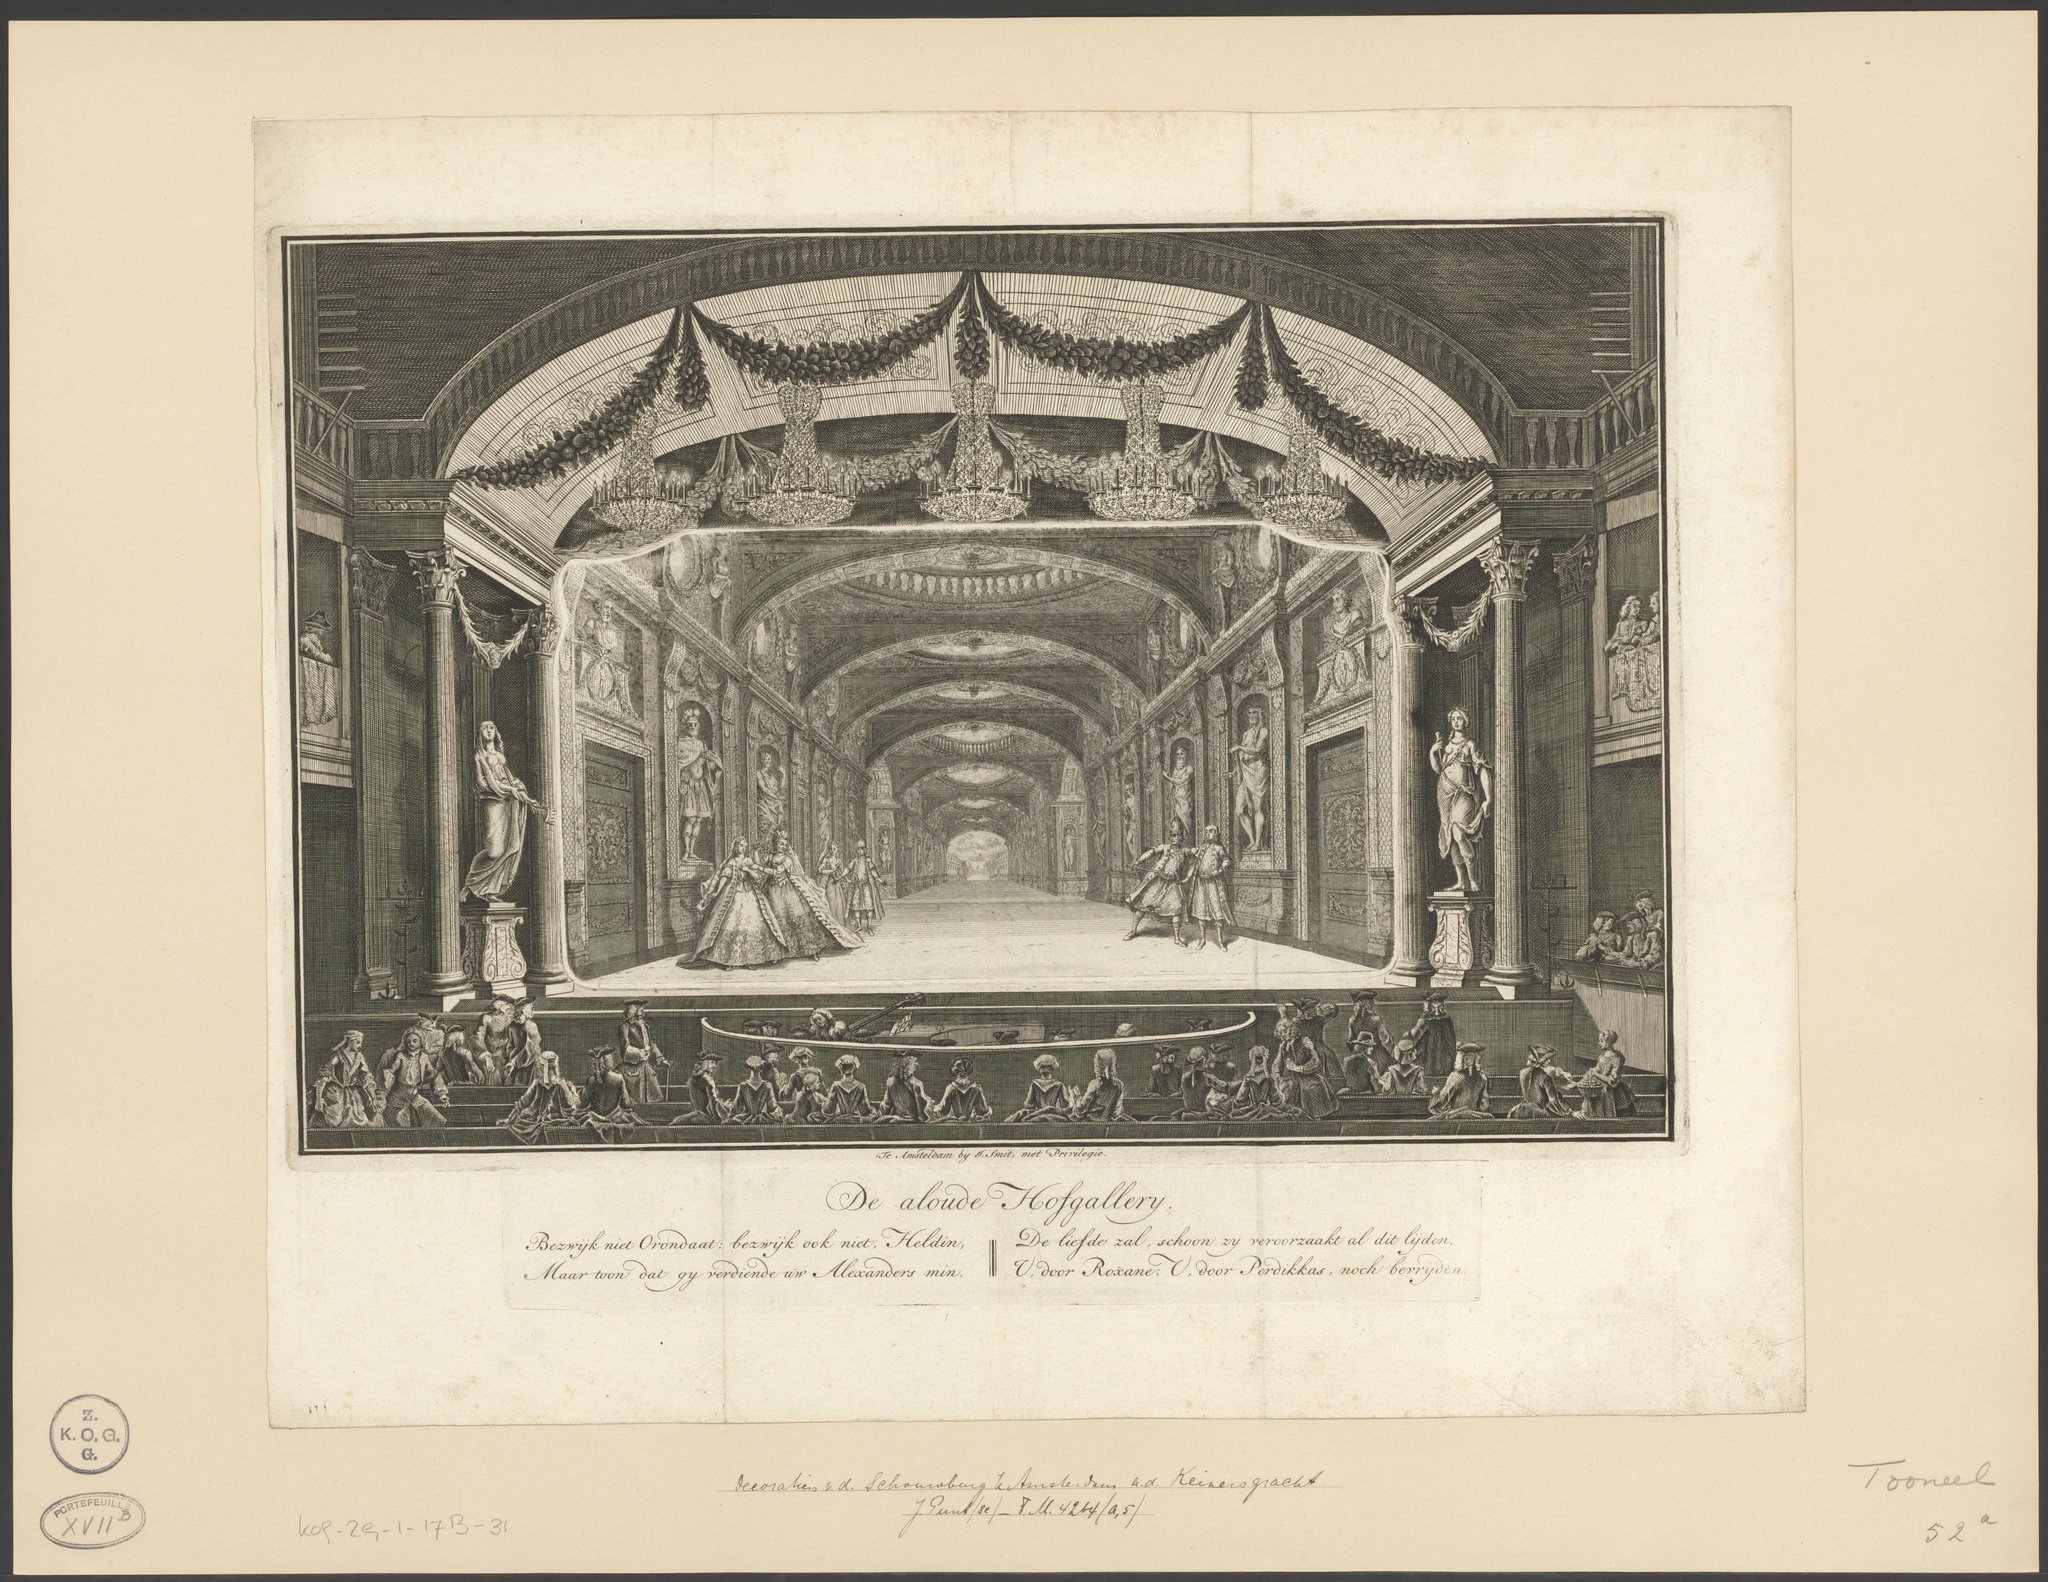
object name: print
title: Schouwburg met toneeldecor: De aloude Hofgallery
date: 1736-1738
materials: paper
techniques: engraving, etching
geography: amsterdam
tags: theatre, theatrical performance, stage design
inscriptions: stamp, collector's mark: Lugt 1641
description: Scène uit het toneelstuk "Het huwelyk van Orondates en Statira. Treurspel." door Jean Magnon (vertaald door D. Lingelbach), Amsterdam 1715. Deze platen zijn in verschillende groepen in verschillende periodes vervaardigd tussen 1738-1760 en uitgegeven in verschillende series ca. 1760 (met dit passe-partout) en ca. 1770-1772 (met een ander passe-partout). De platen zijn door Muller ingedeeld bij de platen van de brand van de Amsterdamse Schouwburg in 1772. Dit passe-partout is in vier staten uitgegeven. Op de eerste staat staan geen vervaardigers vermeld. Op de tweede staat staat vermeld: Getekent en Uyt gegeven door Hend.k de Leth, in de Visser; in 't Koper gebragt door Adolf van der Laan. Op de derde staat staat de uitgever: J. Smit Exudit. Op de vierde staat is de uitgever en het privilege vermeld: Te Amsterdam bij J. Smit, met Privilegie.